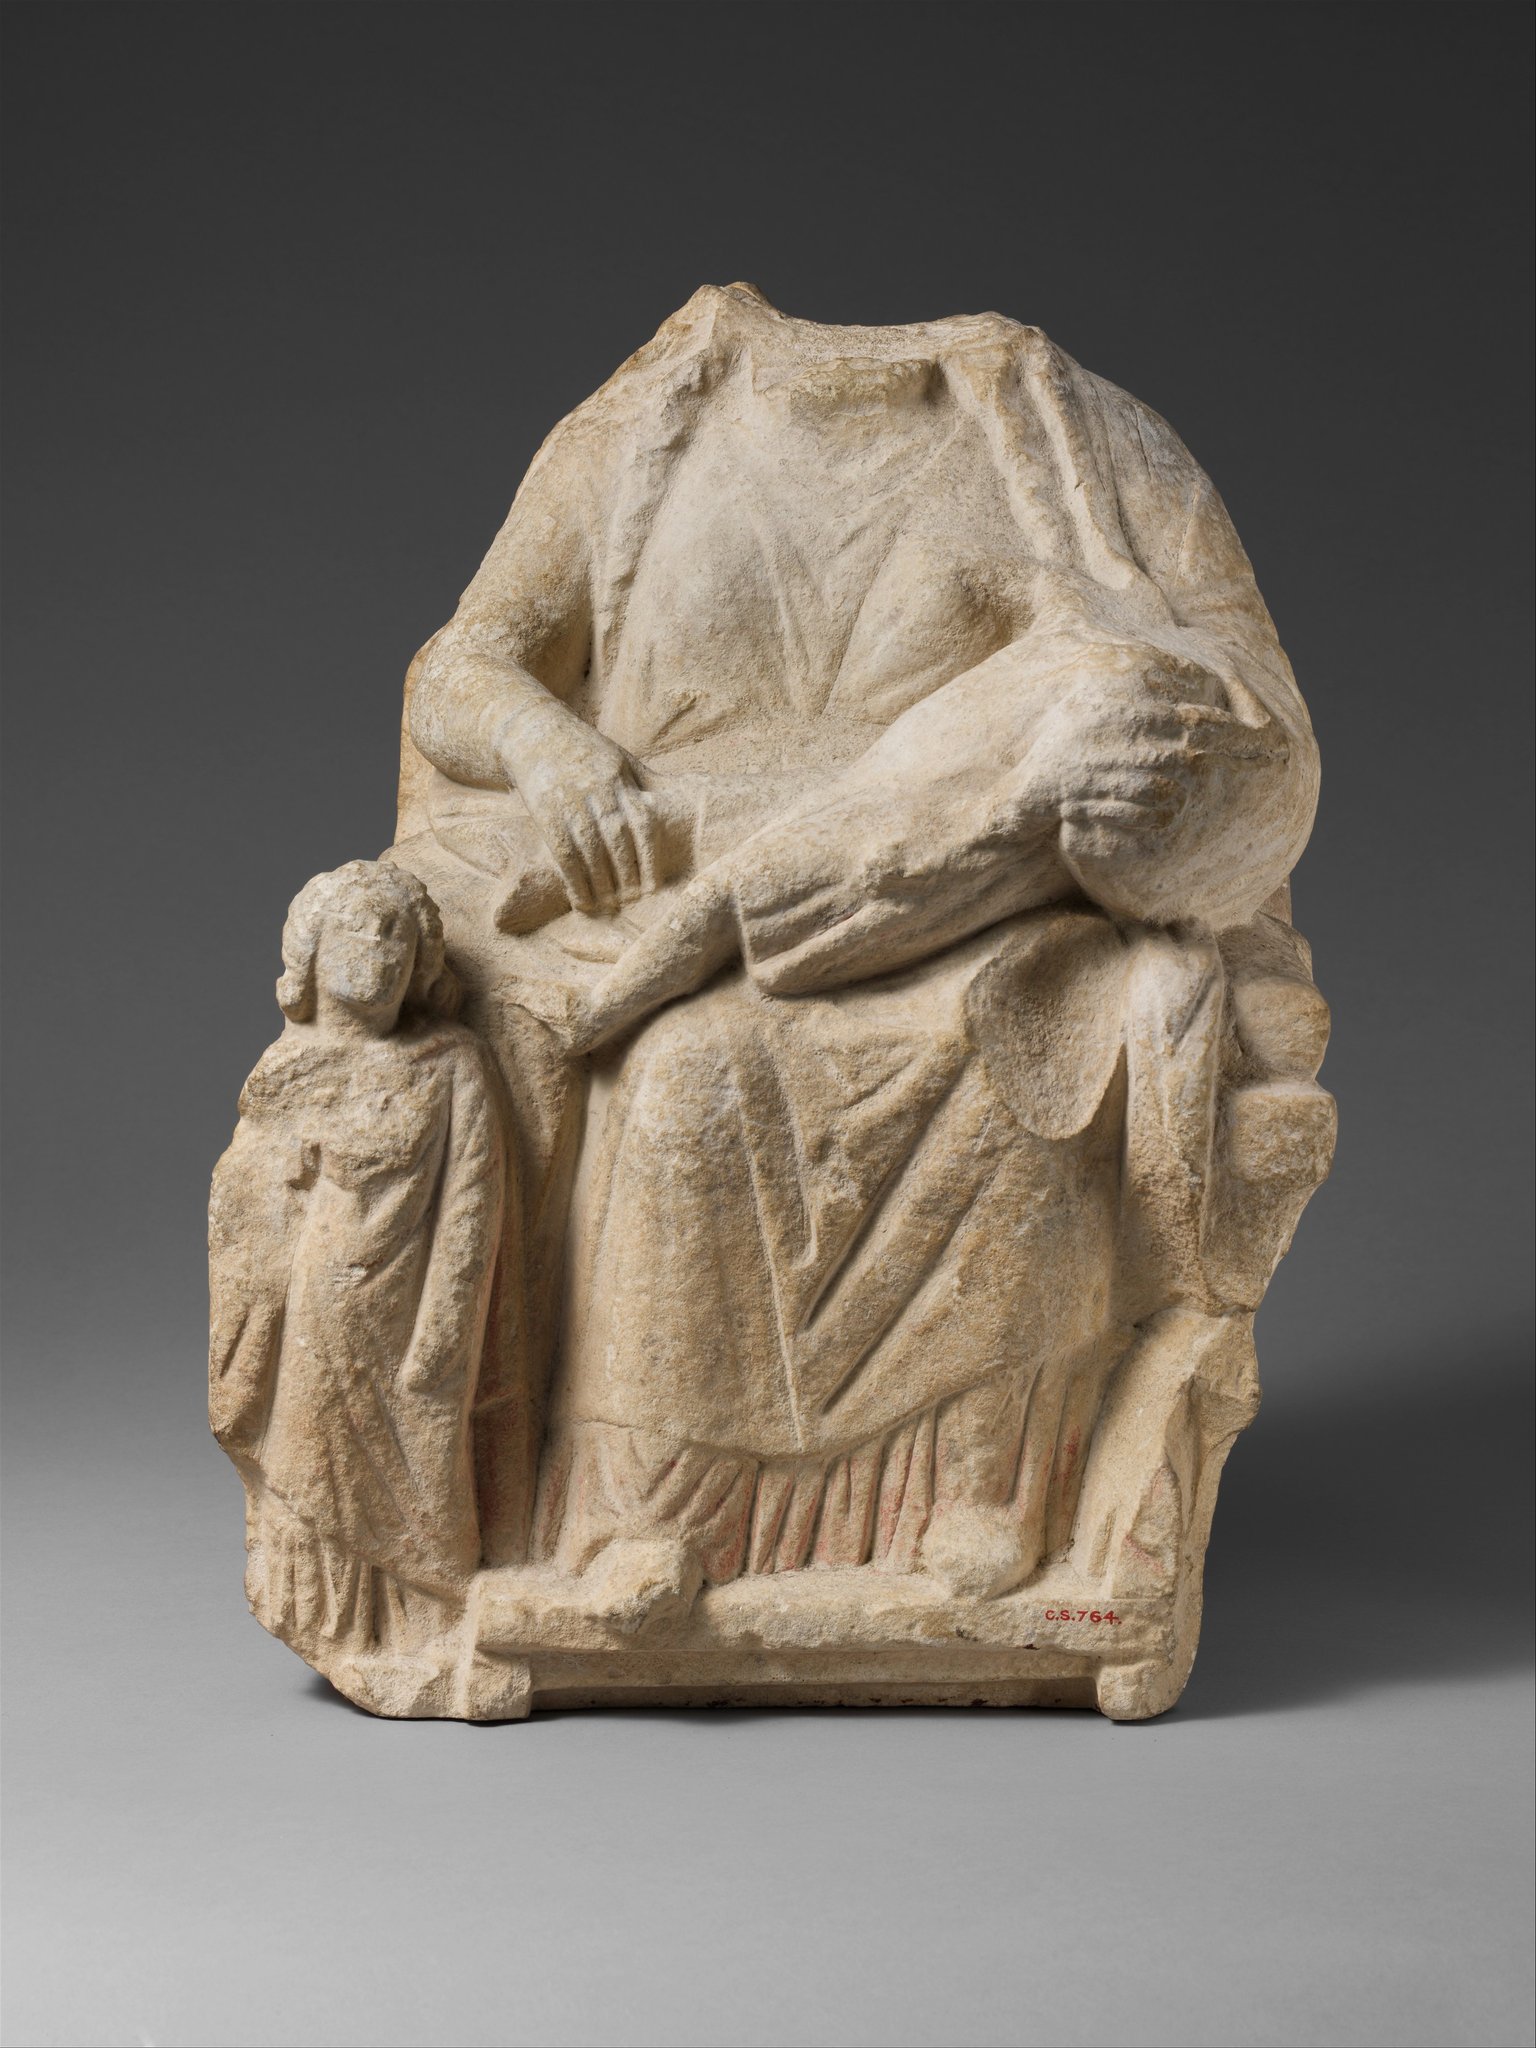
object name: statue of a woman with child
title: Seated limestone kourotrophos with another child standing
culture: cypriot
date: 400-301 BCE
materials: limestone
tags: children,women